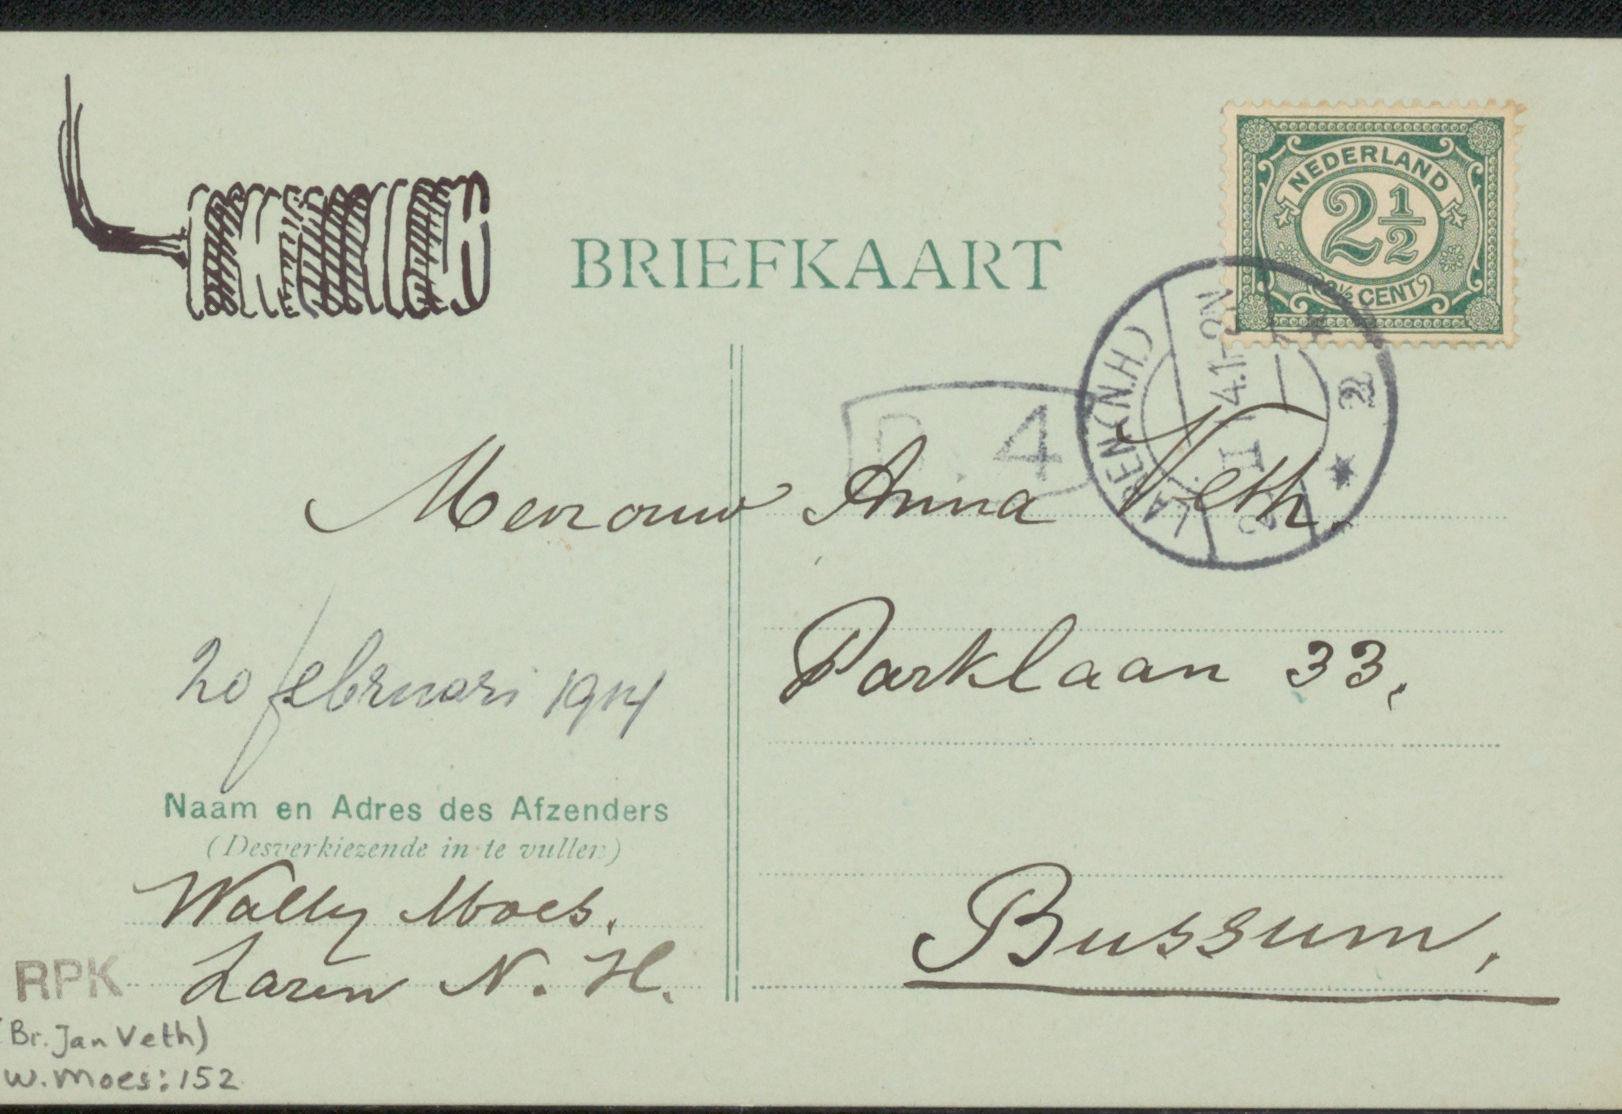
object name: postcard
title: Briefkaart aan Anna Dorothea Dirks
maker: wally moes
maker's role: draughtsman, print maker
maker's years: 1856-1918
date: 1914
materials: cardboard, ink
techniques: pen, writing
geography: laren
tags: artist, anna dorothea dirks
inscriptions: collector's mark: ‘RPK’